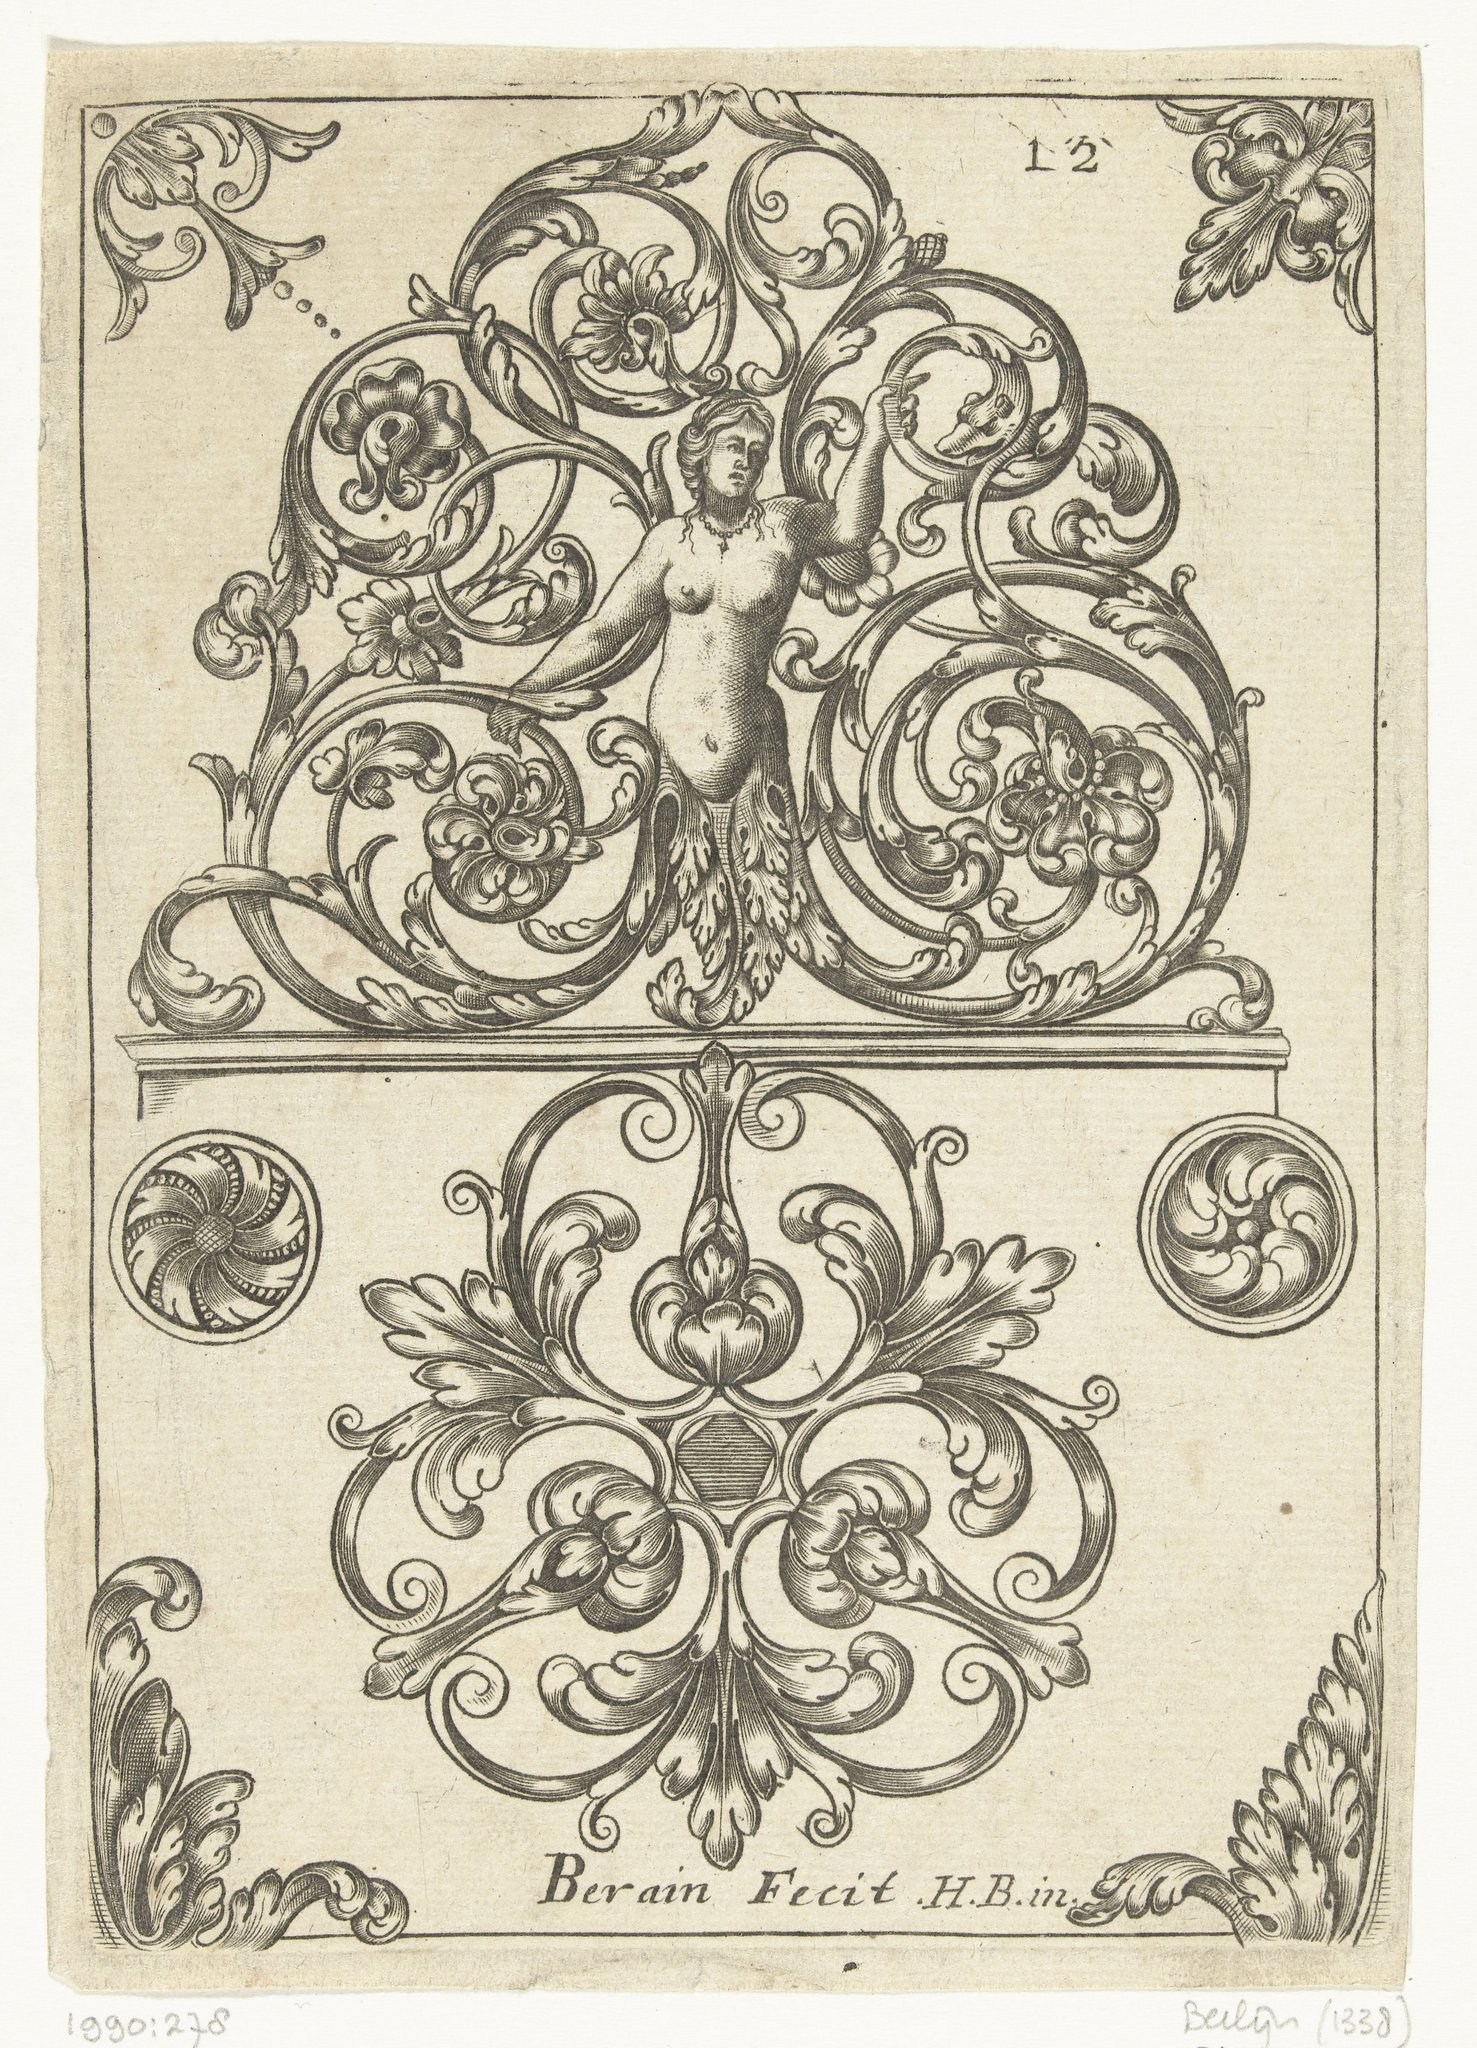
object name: ornament print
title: Diverses Pièces de Serruriers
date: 1662-1711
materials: paper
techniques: engraving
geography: paris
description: Met een rozet rond een vijfhoekig gat onderaan en het bovenlichaam van een naakte vrouw tussen bladranken bovenaan. Blad 12 uit serie van titelblad, blad met opdracht en 14 bladen met beslag en smeedwerk, sleutelgatplaten, sleutels, deurkloppers en deurknoppen. Tweede editie.